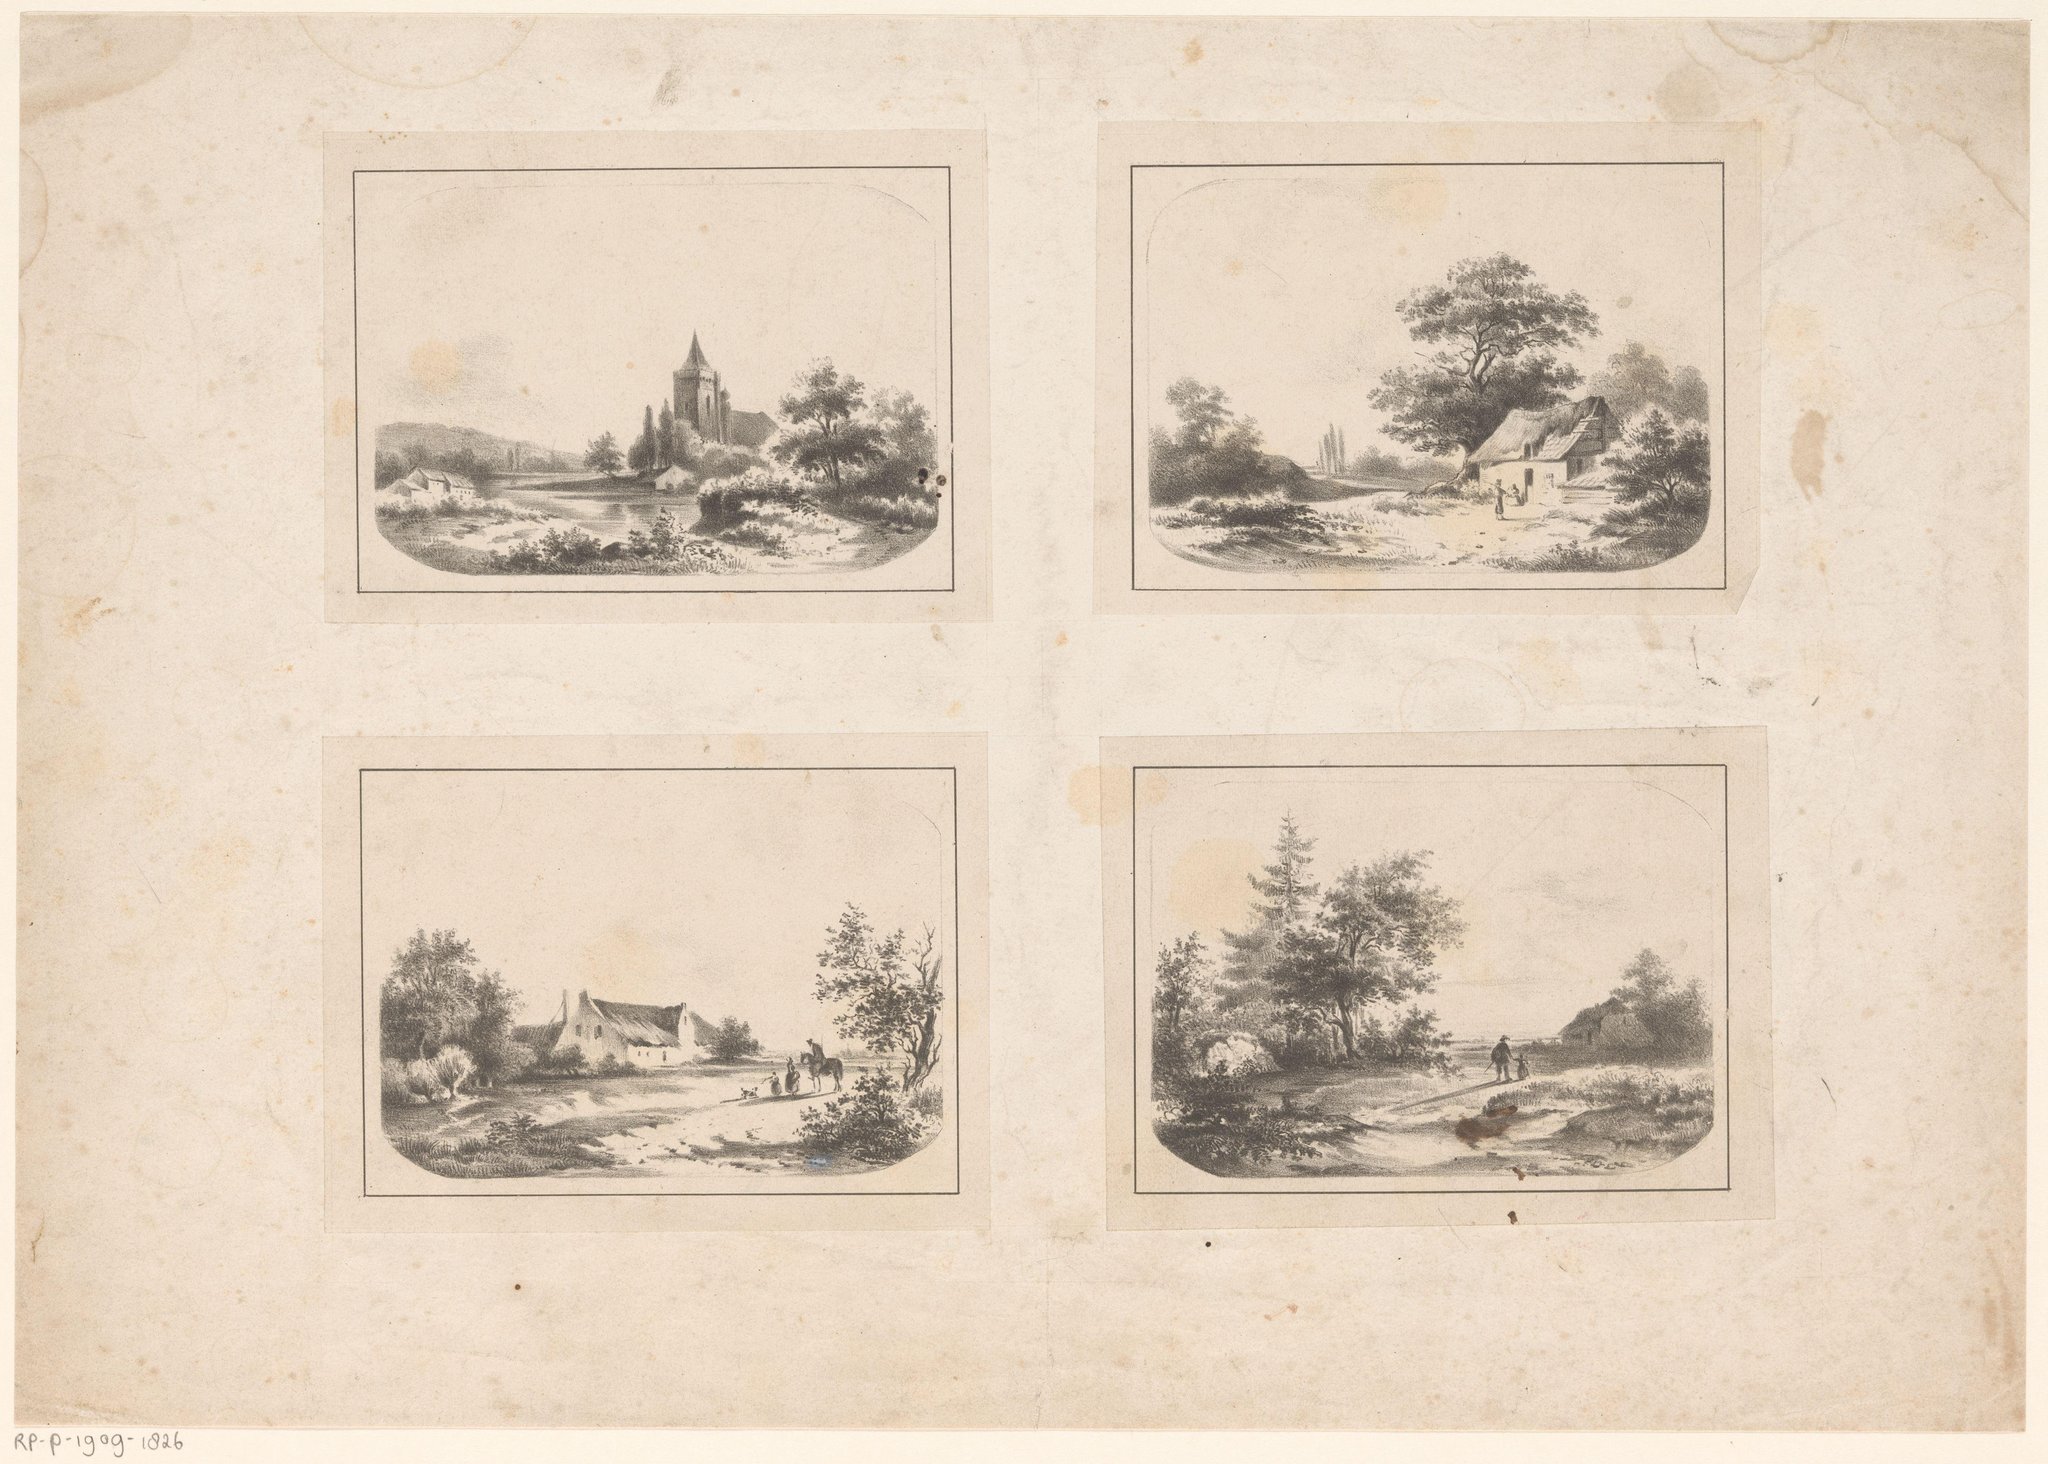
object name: print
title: Vier landschappen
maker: Anonymous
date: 1809-1899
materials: paper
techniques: lithograph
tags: landscapes in the temperate zone, farm or solitary house in landscape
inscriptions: collector's mark: Lugt 2228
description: In het landschap linksboven staat een kerk, in de andere drie landschappen een boerderij met figuren.